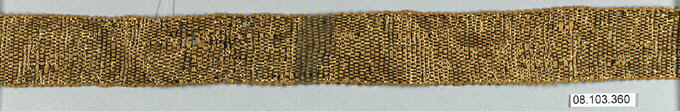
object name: galloon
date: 1601-1800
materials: metal thread, silk